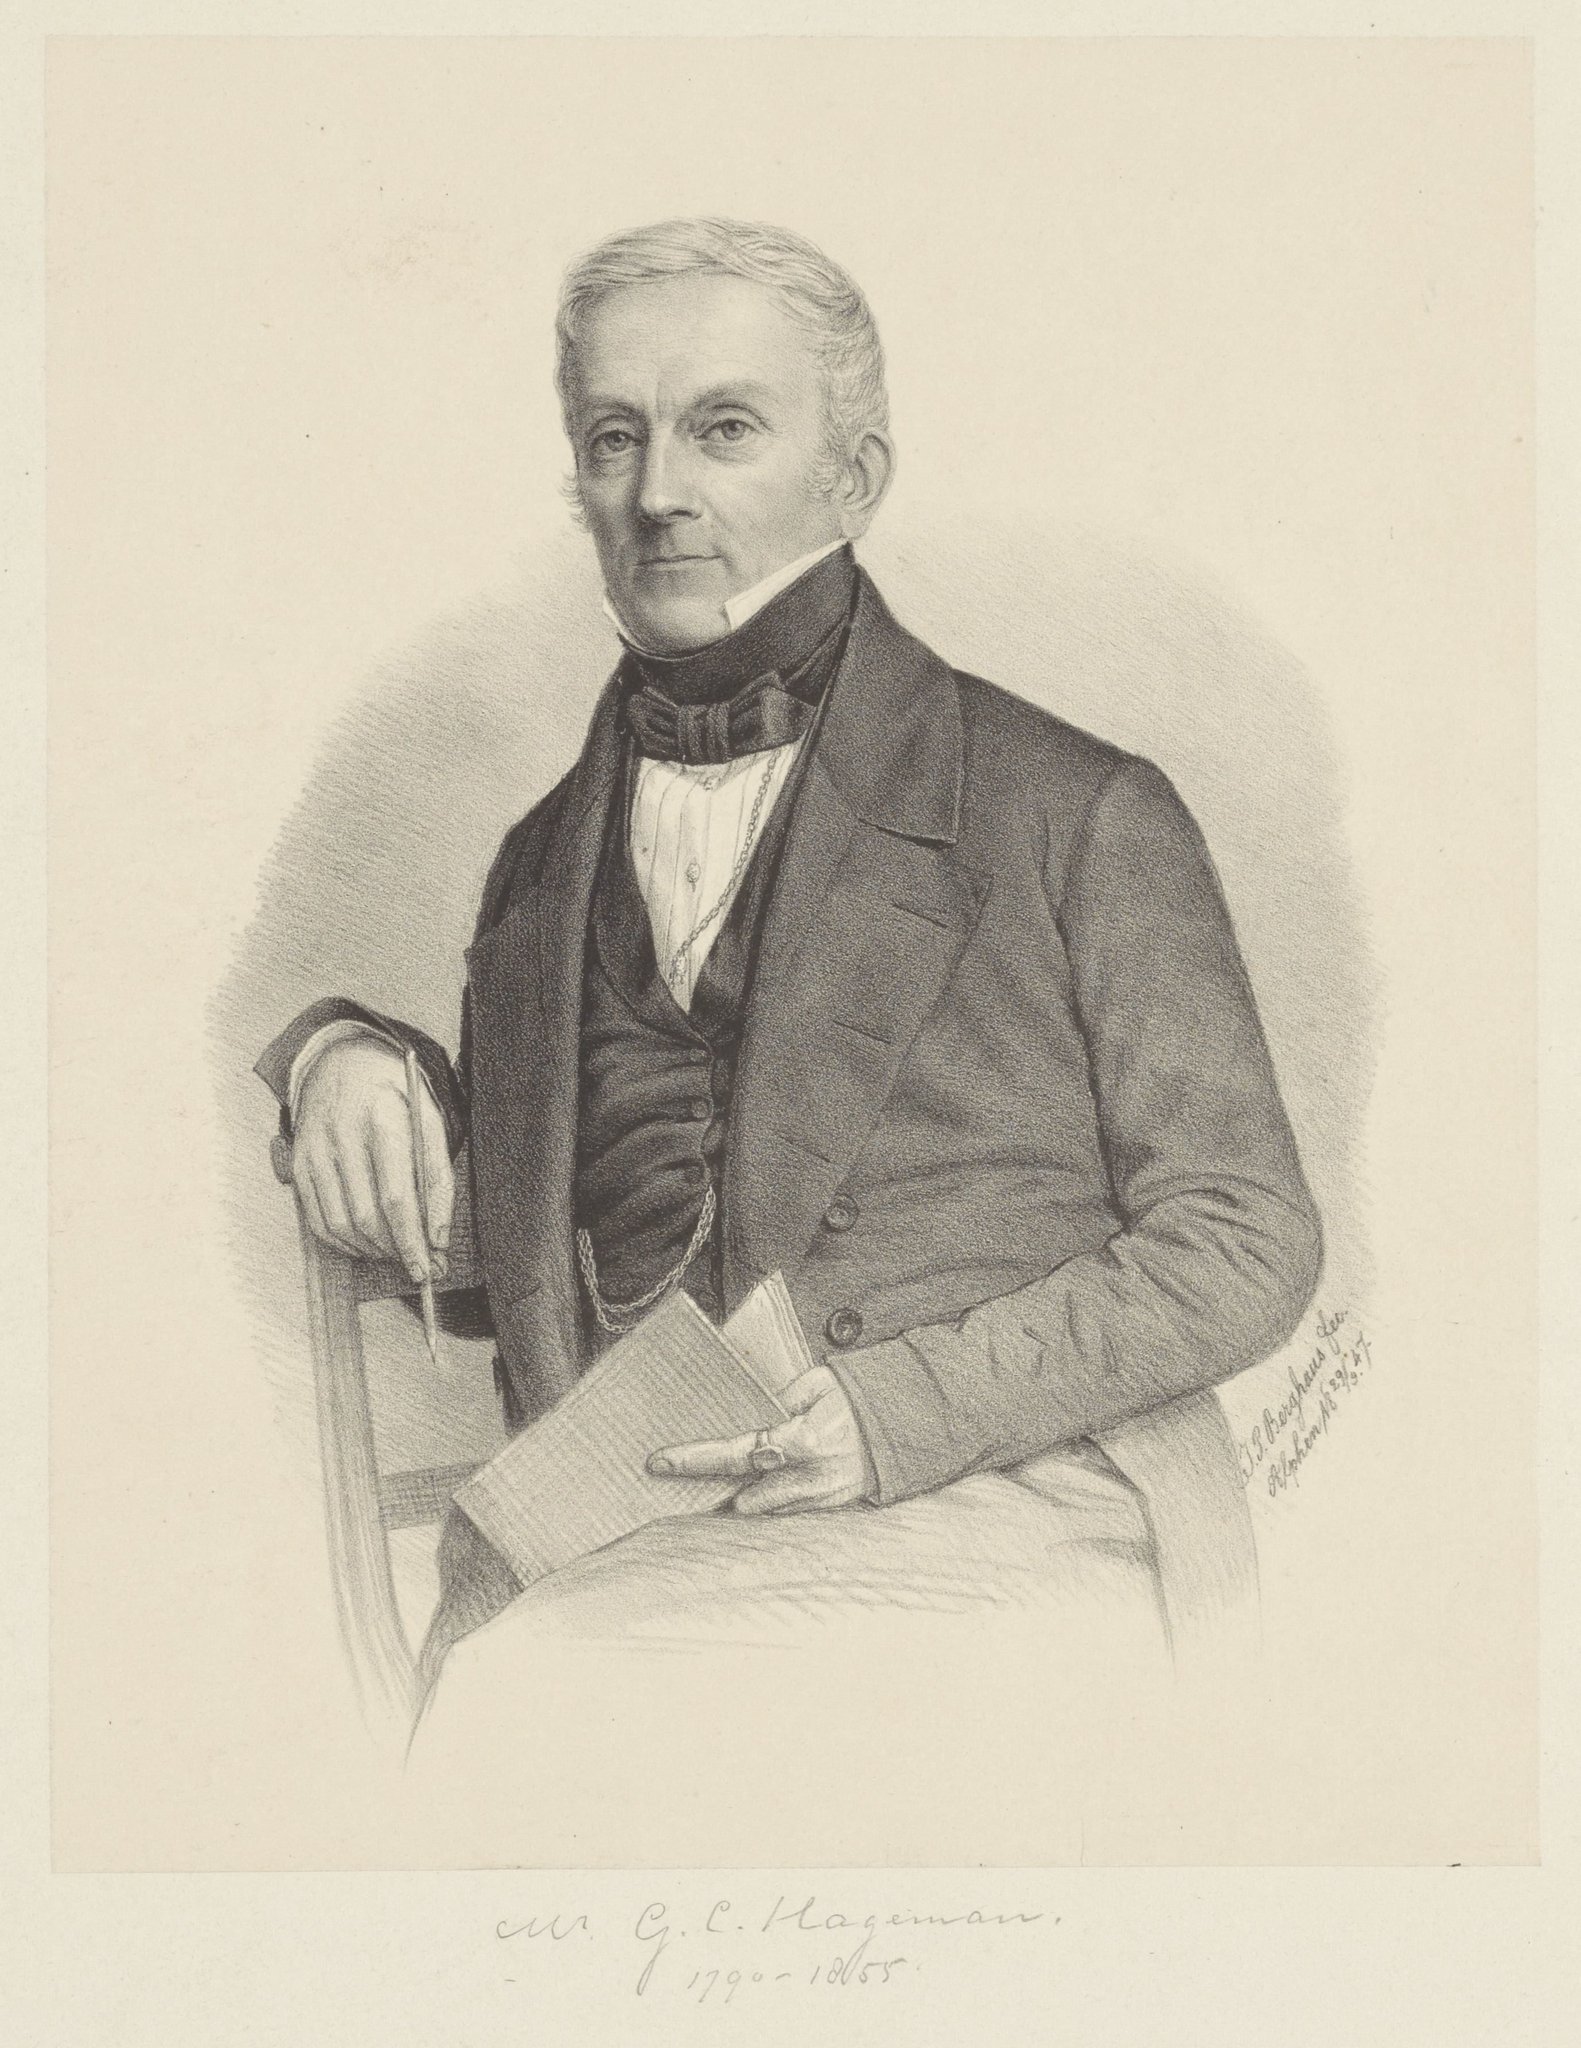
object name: print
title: Portret van een onbekende man, mogelijk Georg Carel Hageman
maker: johann peter berghaus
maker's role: print maker, printer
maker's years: 1810-1870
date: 1847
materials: paper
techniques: lithograph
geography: alphen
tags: historical persons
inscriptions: collector's mark: Lugt 2228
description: De geportretteerde zit op een stoel en leunt met zijn rechterarm over de rug. In zijn recterhand heeft hij een boek, zijn vingers tussen de bladzijden. In zijn linkerhand heeft hij een potlood.